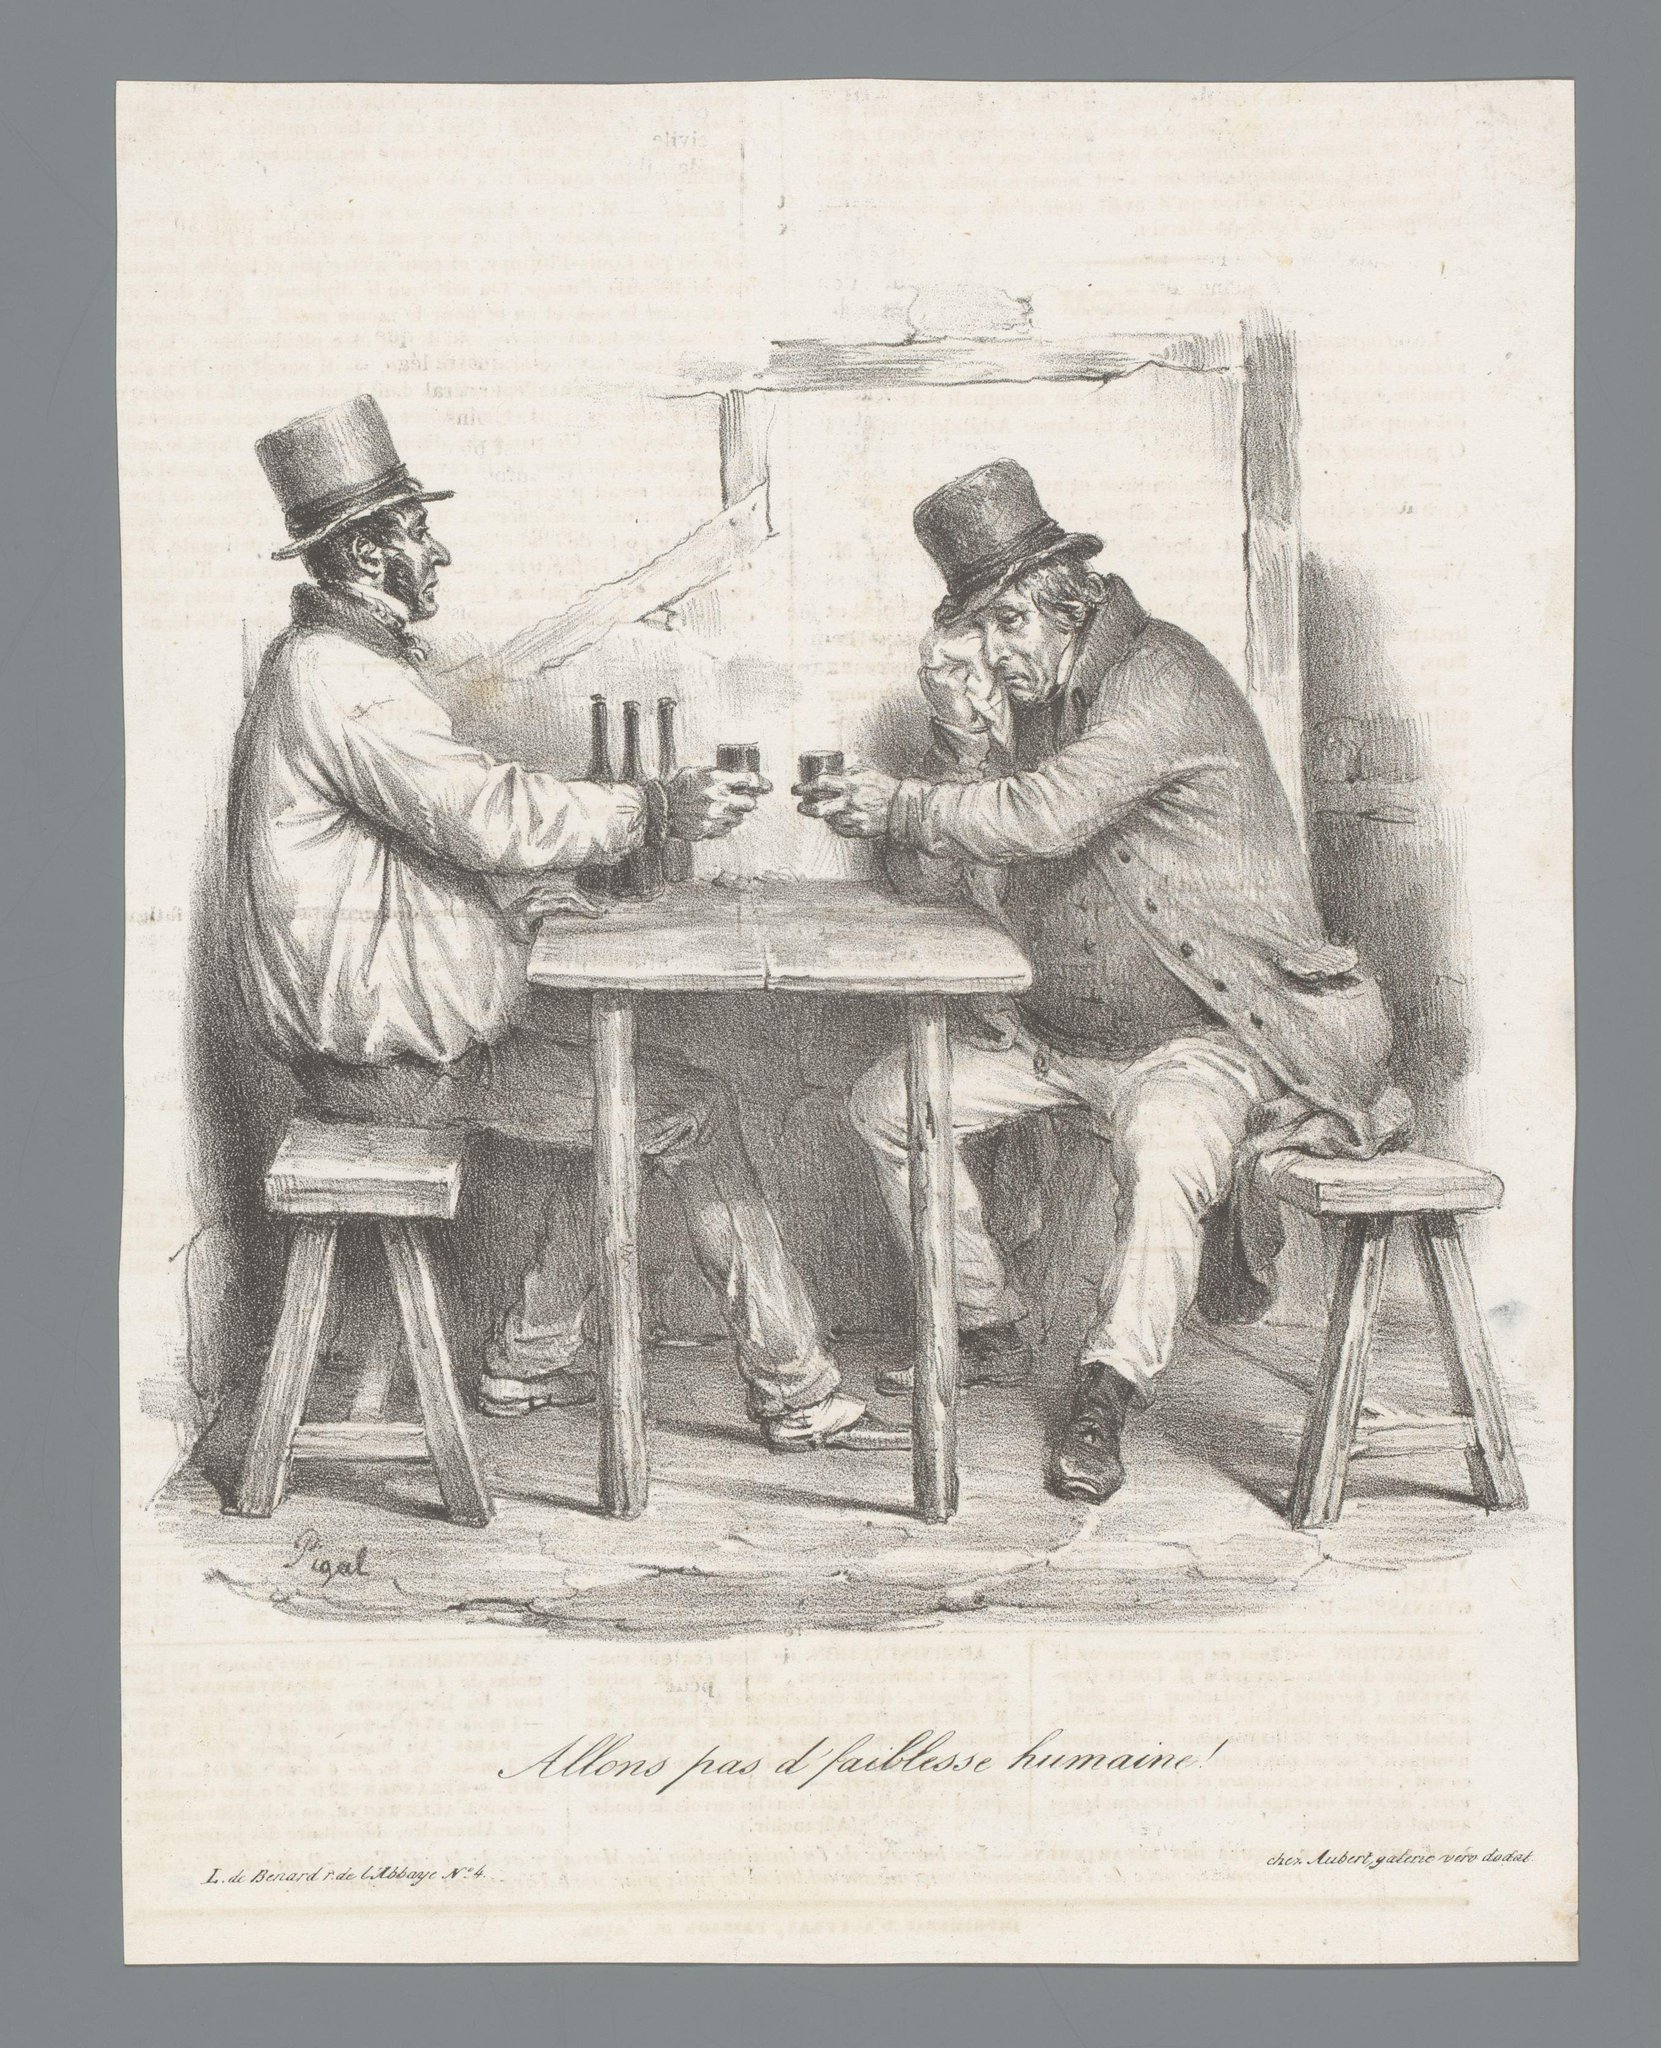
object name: print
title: Twee treurig kijkende mannen nemen een drankje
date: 1833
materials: paper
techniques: letterpress printing, lithograph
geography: paris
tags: adult man ( + one person), drinking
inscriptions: collector's mark: Lugt 2228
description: Prent uit: Le Charivari 2 (1833), nr. 143, 27 april 1833.